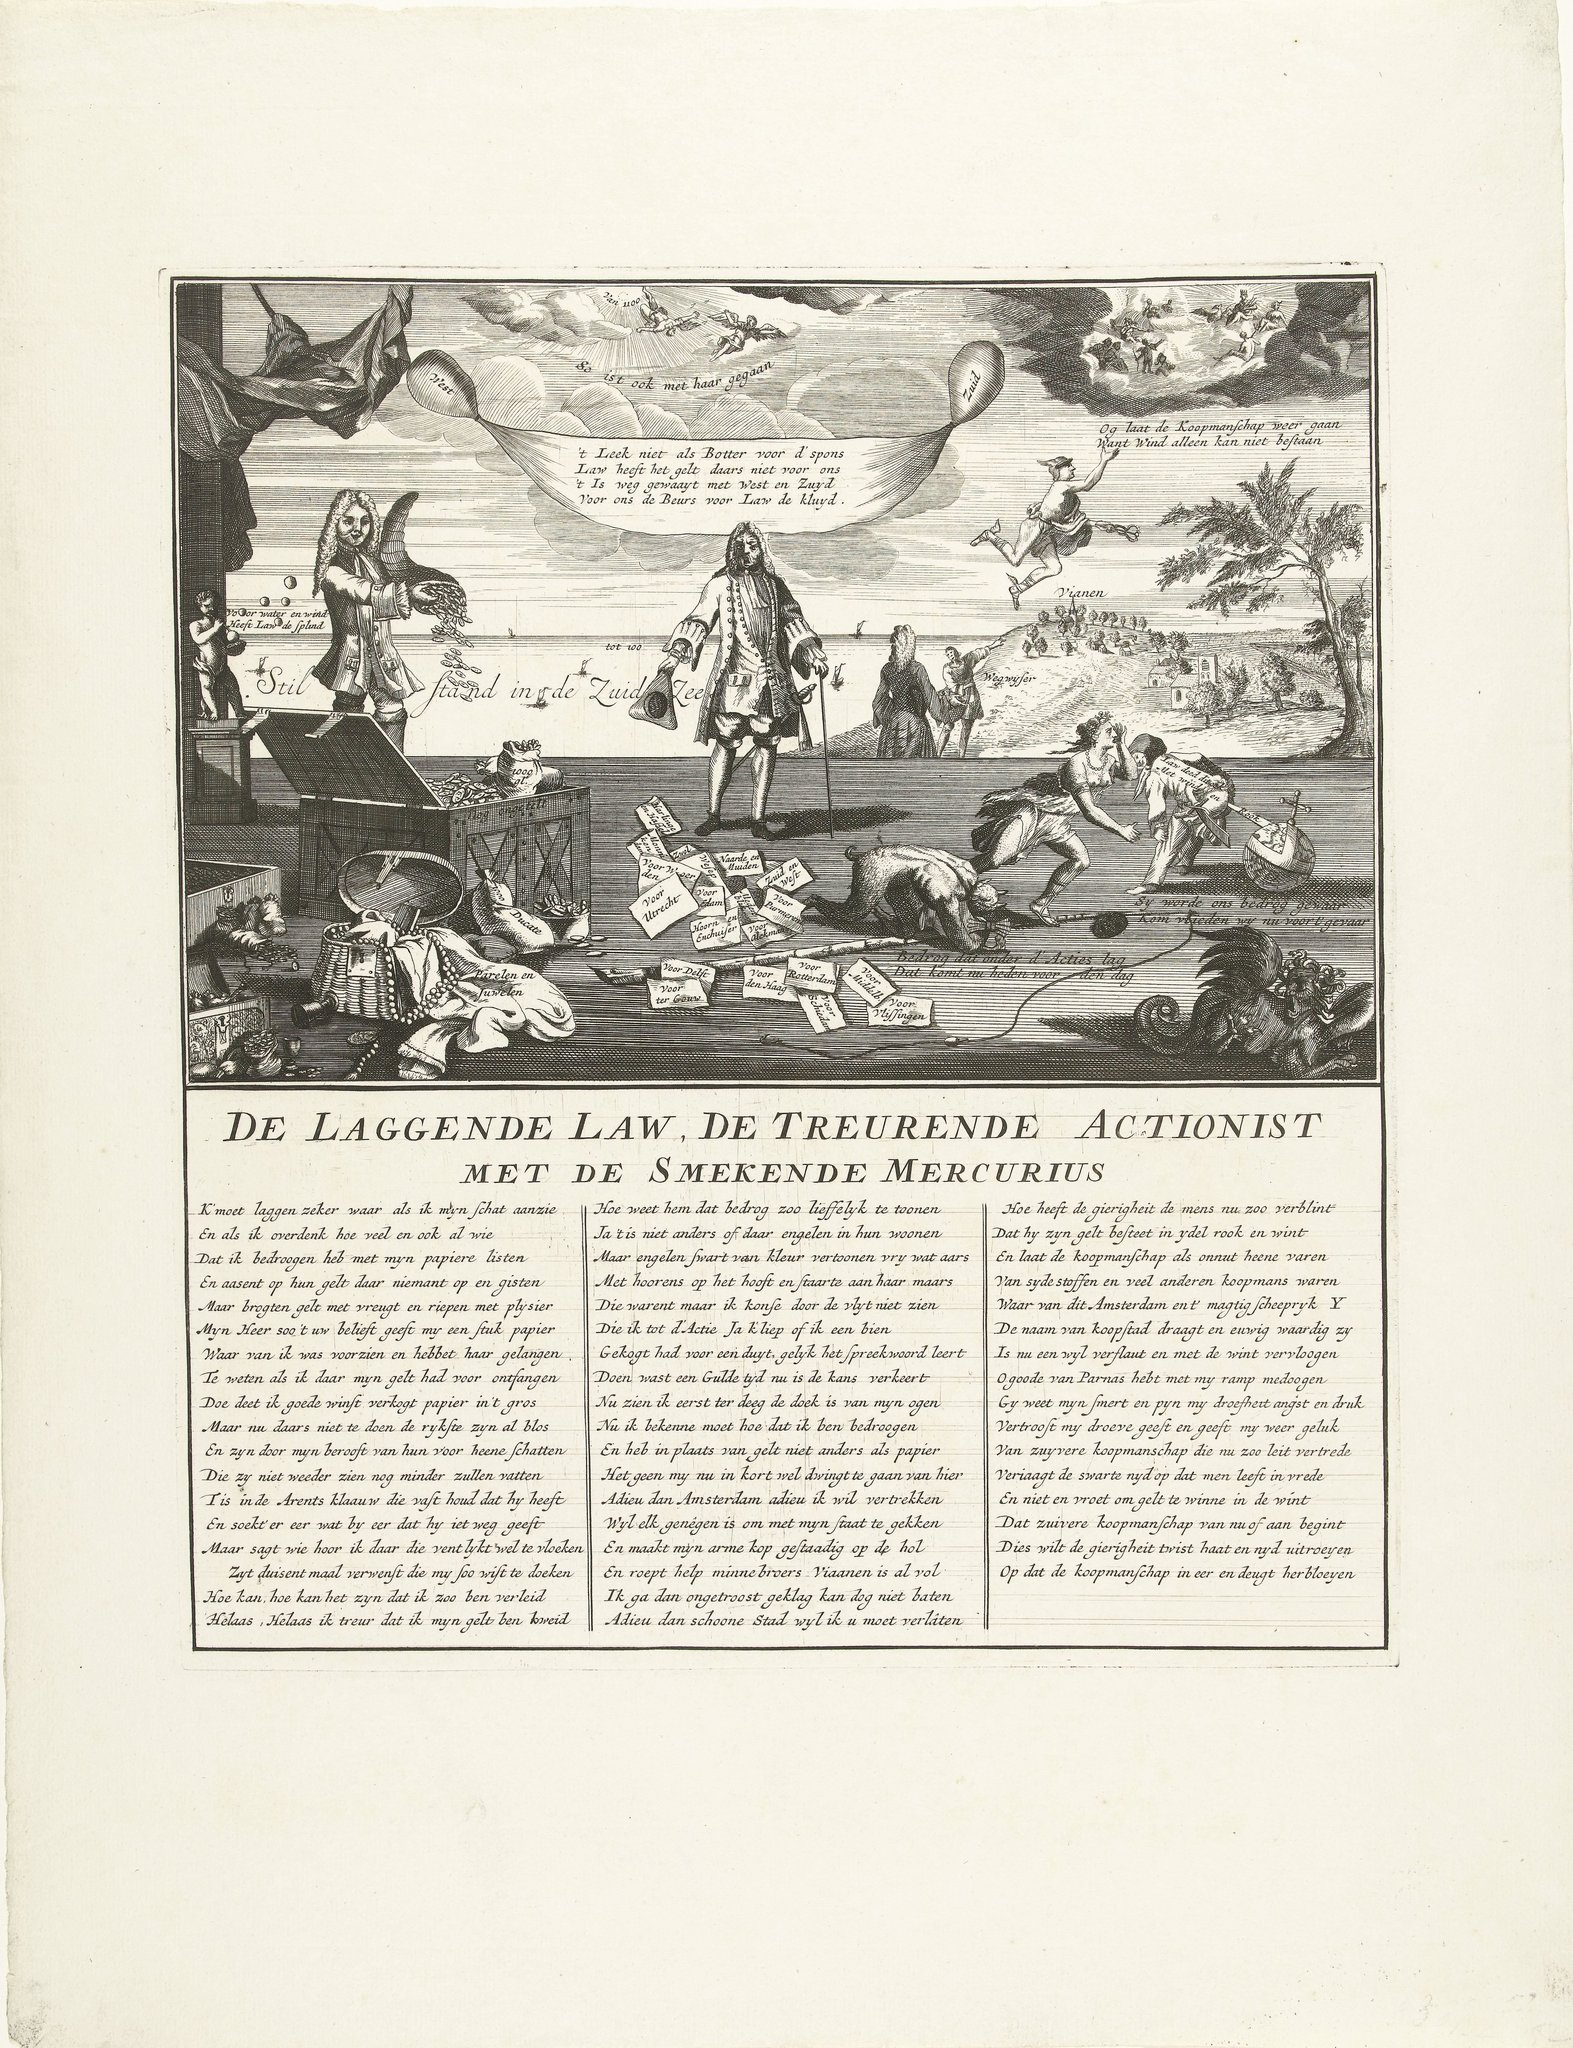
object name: print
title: De Laggende Law, de Treurende Actonist met de Smekende Mercurius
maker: Anonymous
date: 1720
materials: paper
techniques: etching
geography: northern netherlands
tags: econoom, john law, vianen, windhandel van 1720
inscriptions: collector's mark: Lugt 2228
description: Toneel met de Lachende Law, de Treurende Actonist en de Smekende Mercurius. Links vult een lachende John Law zijn geldkist, in het midden een wanhopige windhandelaar, rechts smeekt Mercurius de goden om herstel van het Koopmanschap. Op de achtergrond verwijzingen naar de projecten in de Zuidzee en te Vianen. Op de voorgrond duivels, actiebriefjes, etc. Met onderschrift in drie kolommen. Prent 52 in de serie Het Groote Tafereel der Dwaasheid met spotprenten op de Windhandel of Actiehandel van 1720.